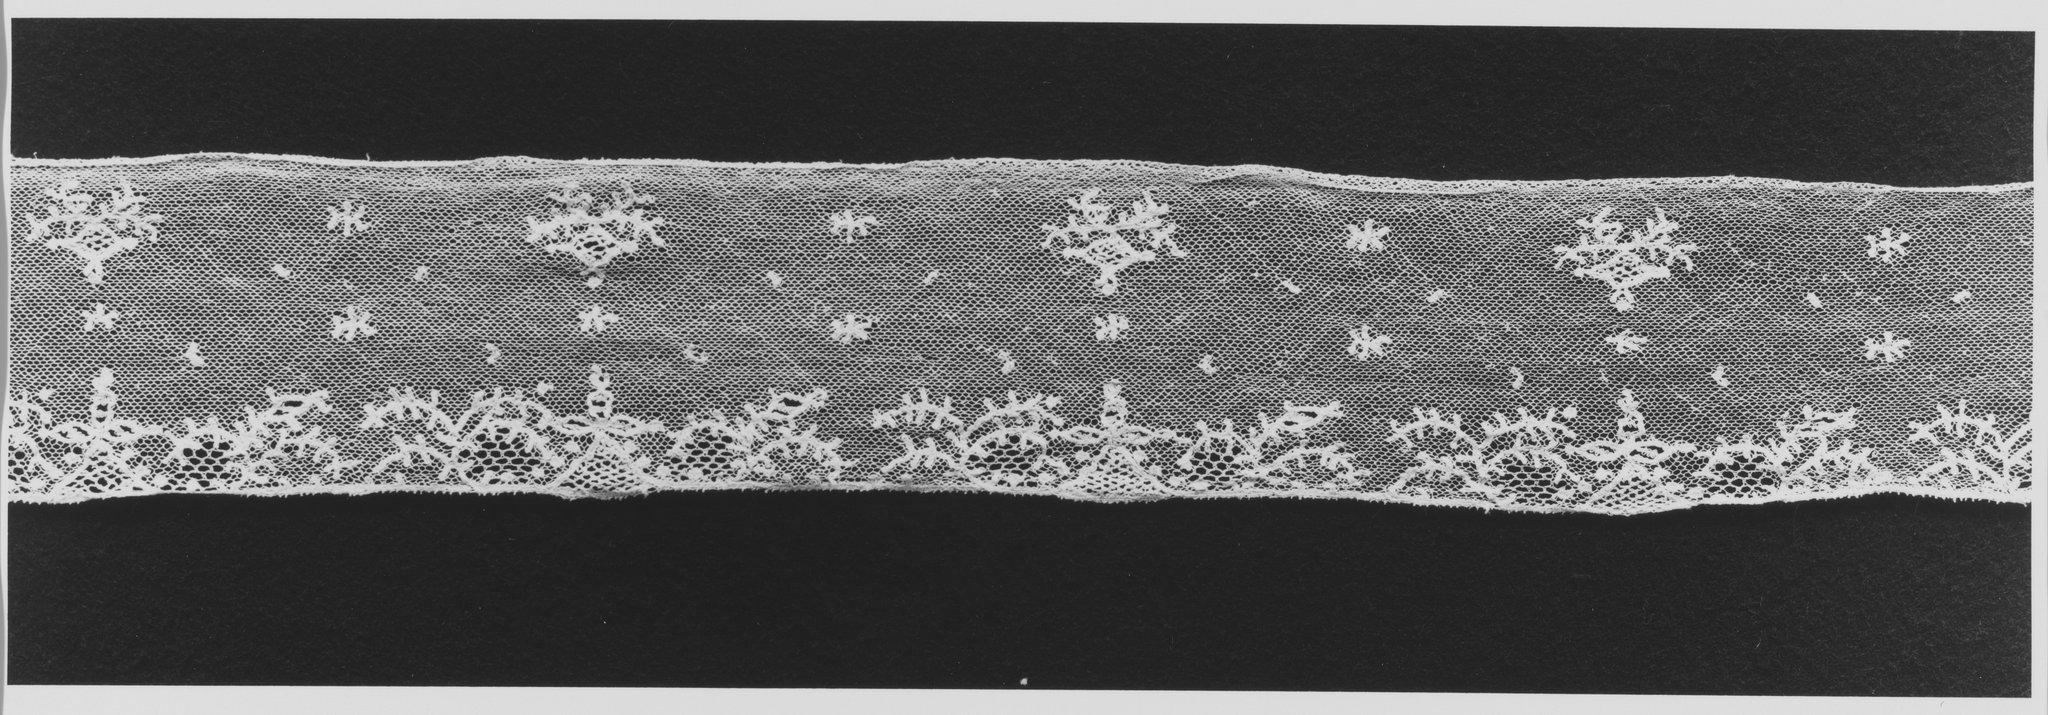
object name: piece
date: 1701-1900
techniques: lace